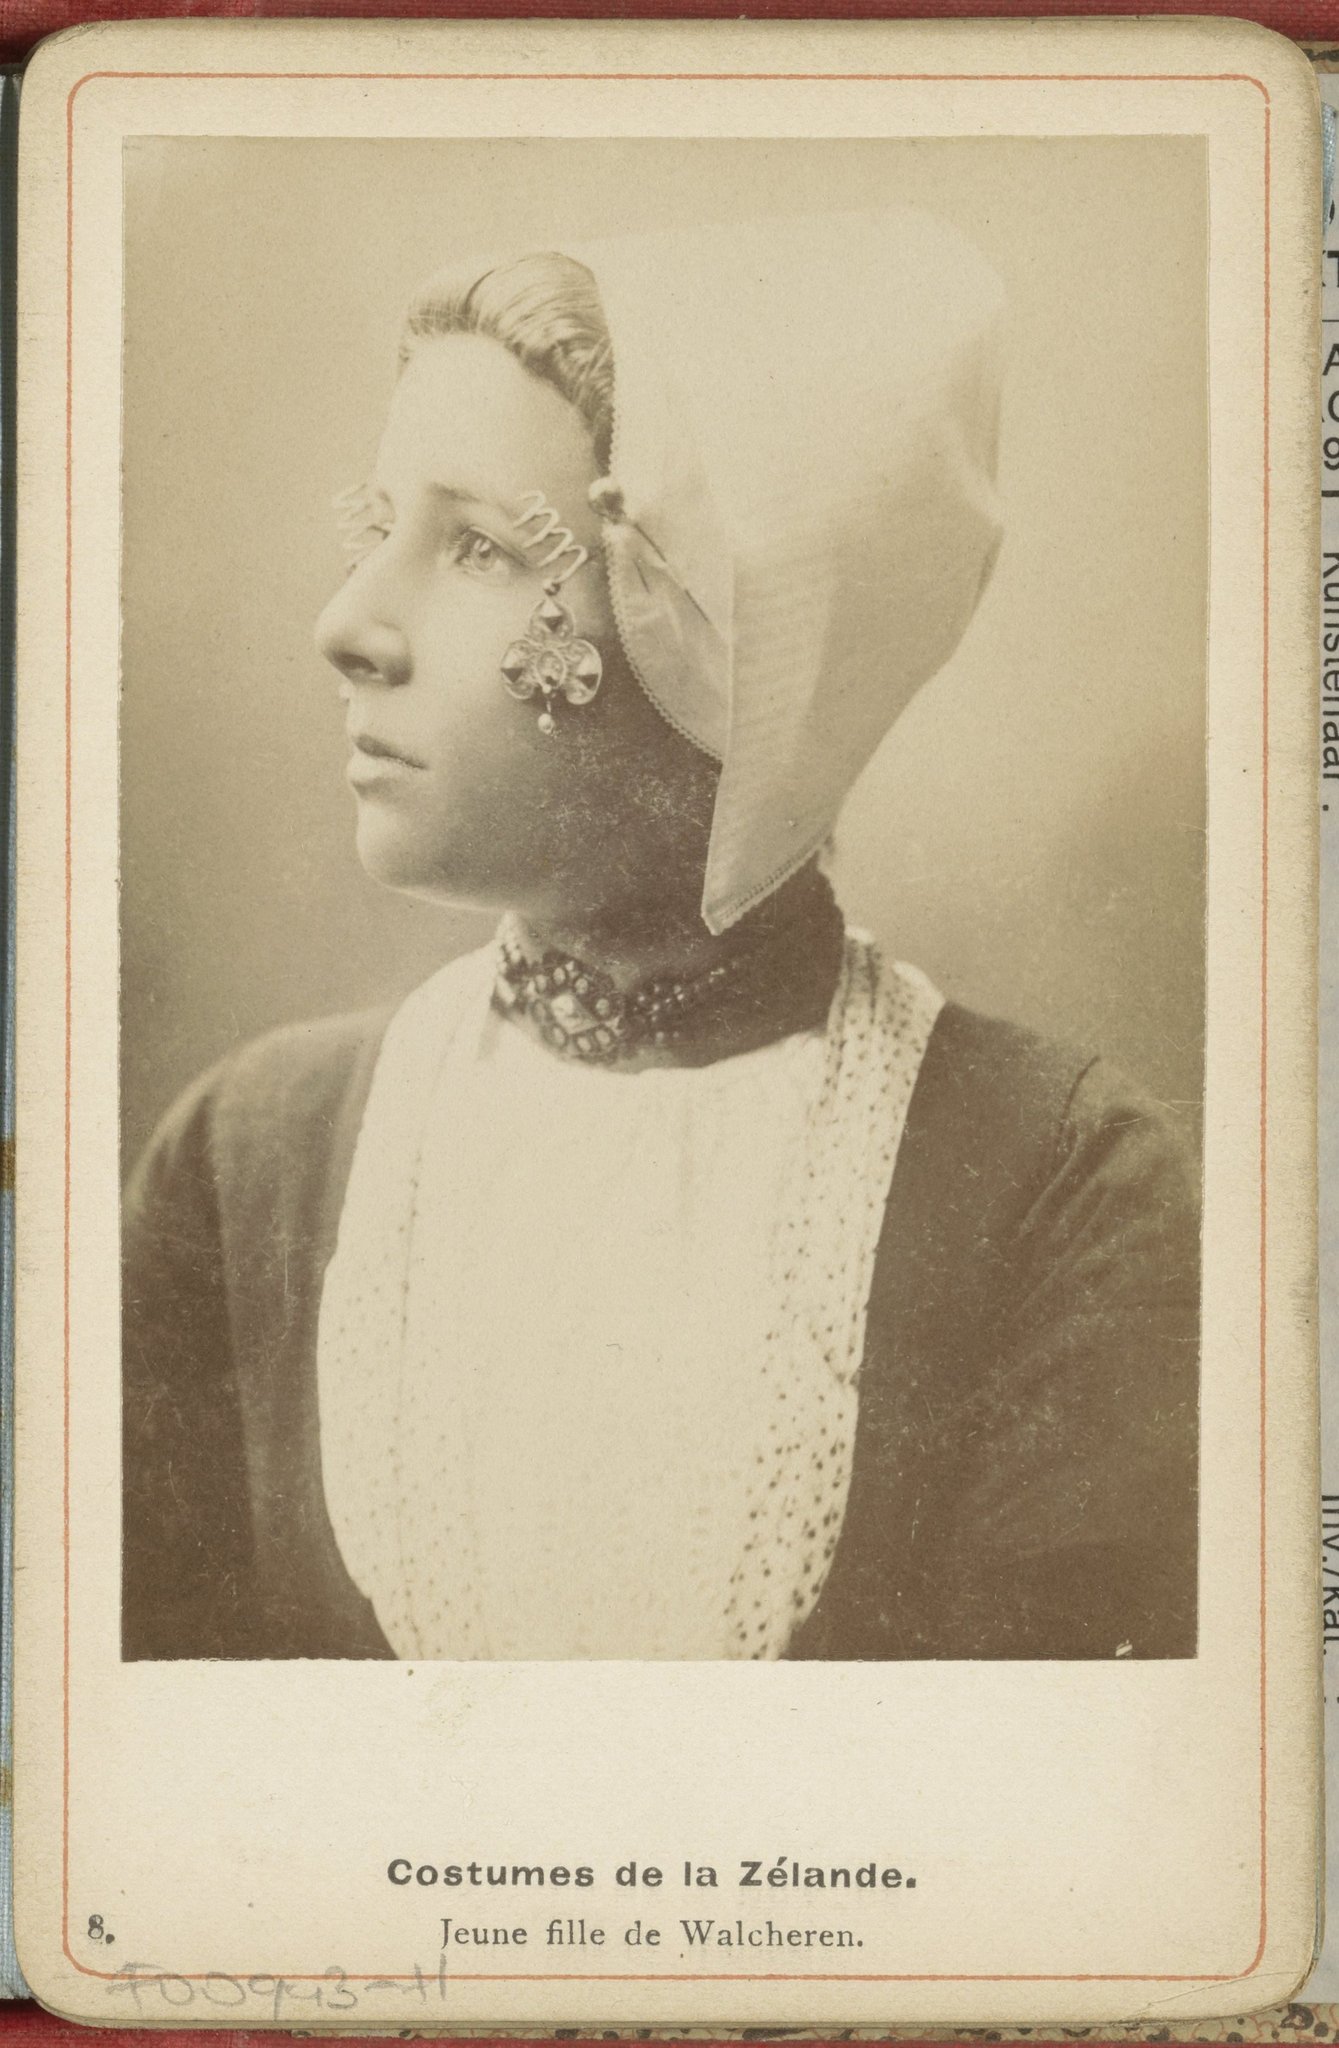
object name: photograph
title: Jeune fille de Walcheren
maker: Anonymous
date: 1870-1910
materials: cardboard, photographic support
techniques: albumen print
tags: folk costume, regional costume (+ women's clothes)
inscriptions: number: ‘8’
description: Onderdeel van Leporelloalbum met Zeeuwse klederdrachten.